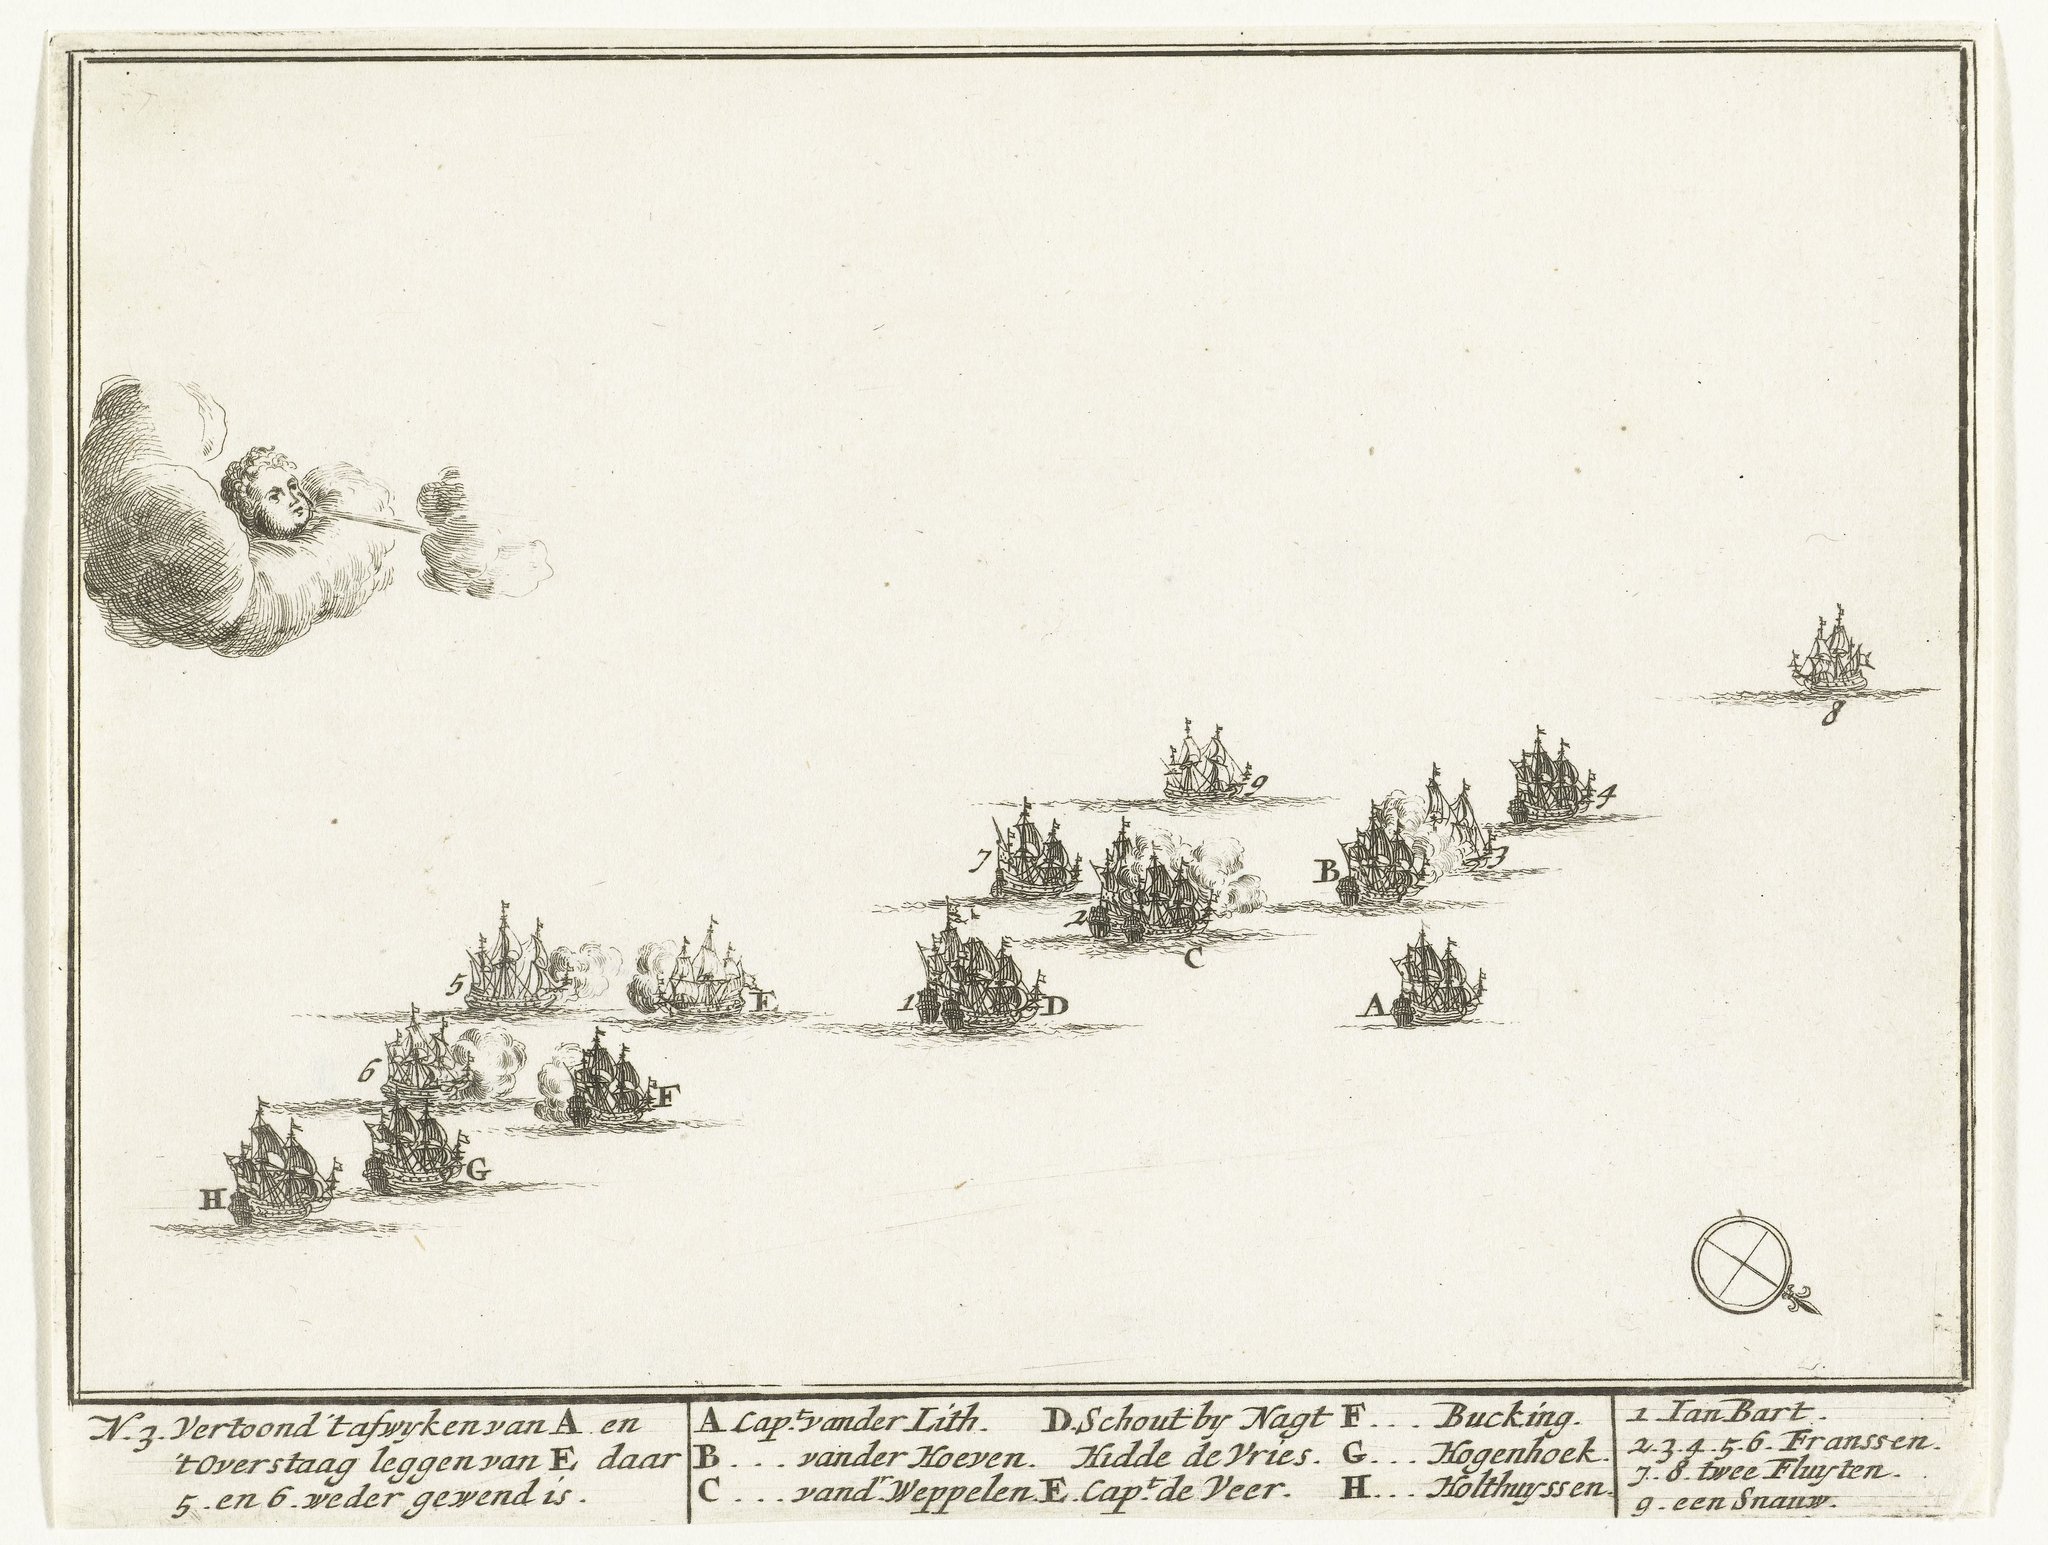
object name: print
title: Zeegevecht tussen Hollanders en Fransen op de Noordzee (plaat 3), 1694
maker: adriaen schoonebeek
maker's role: print maker, publisher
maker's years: 1661-1705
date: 1694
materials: paper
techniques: etching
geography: amsterdam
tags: battle (+ naval force)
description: Zeegevecht tussen Hollanders en Fransen op de Noordzee. Plaat nr. 3 in een serie van 14 genummerde platen van een zeegevecht voorgevallen tussen een Hollands eskader onder Hidde Sjoerds de Vries en Franse schepen onder Jan Bart op de Noordzee, 29 juni 1694.